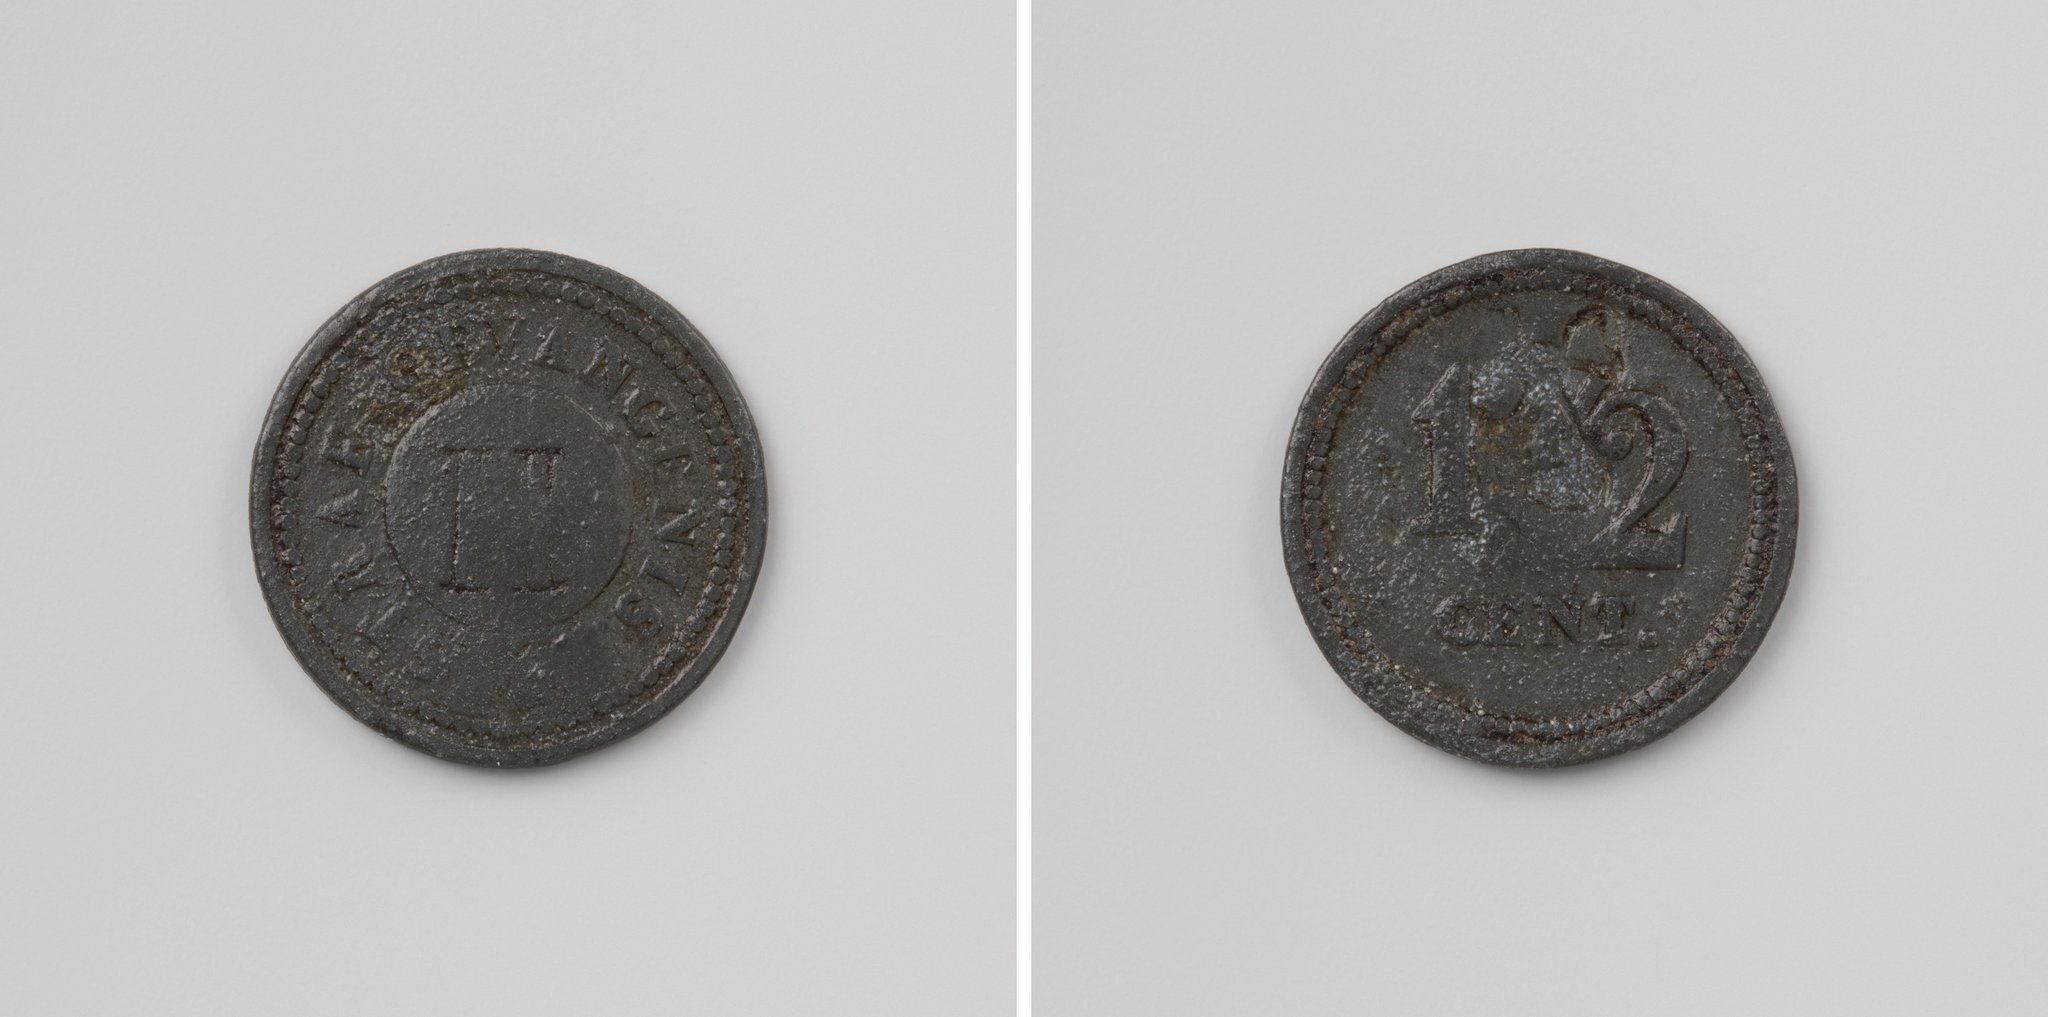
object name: halve cent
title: Strafgevangenis te Hoorn, huismunt ter waarde van een halve cent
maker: Anonymous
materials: zinc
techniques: striking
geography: utrecht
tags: hoorn (north holland)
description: Zinken betaalpenning. Voorzijde: letter H binnen omschrift. Keerzijde: waardeaanduiding